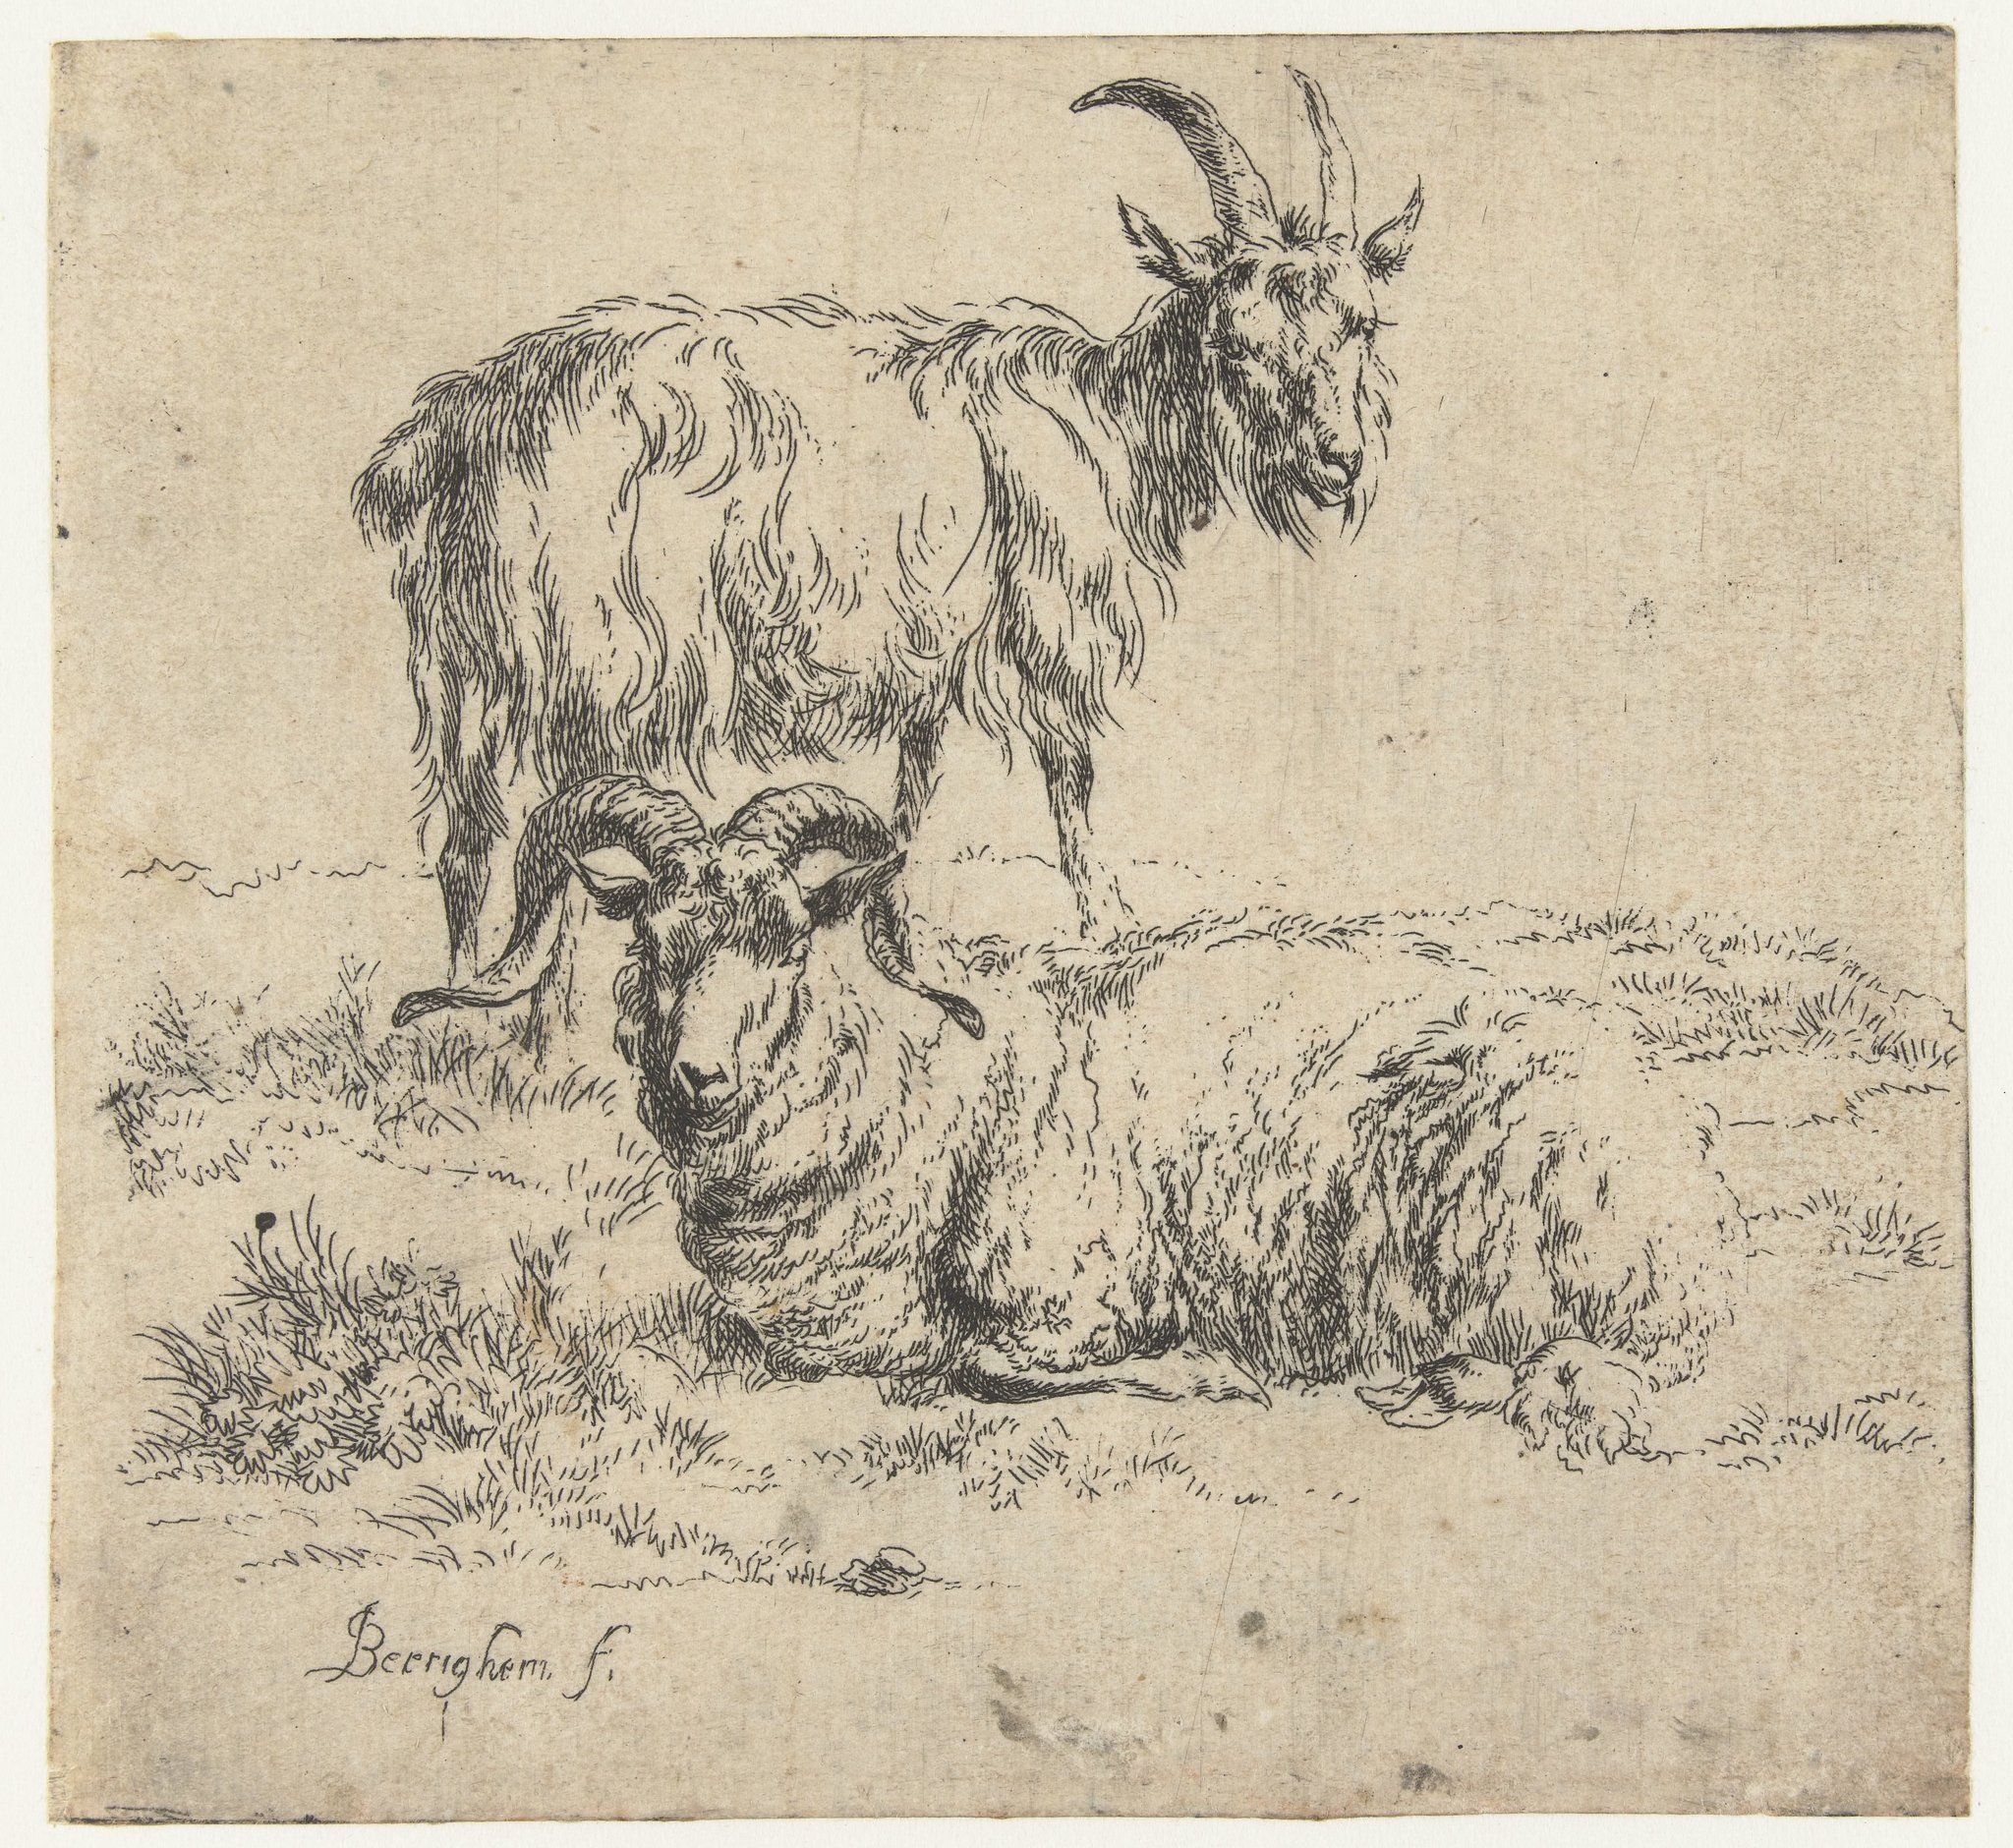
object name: print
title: Verschillende dieren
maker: nicolaes pietersz berchem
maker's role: draughtsman, print maker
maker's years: 1620-1683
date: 1648-1652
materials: paper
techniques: etching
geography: netherlands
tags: ram, goat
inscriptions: collector's mark: Lugt 240